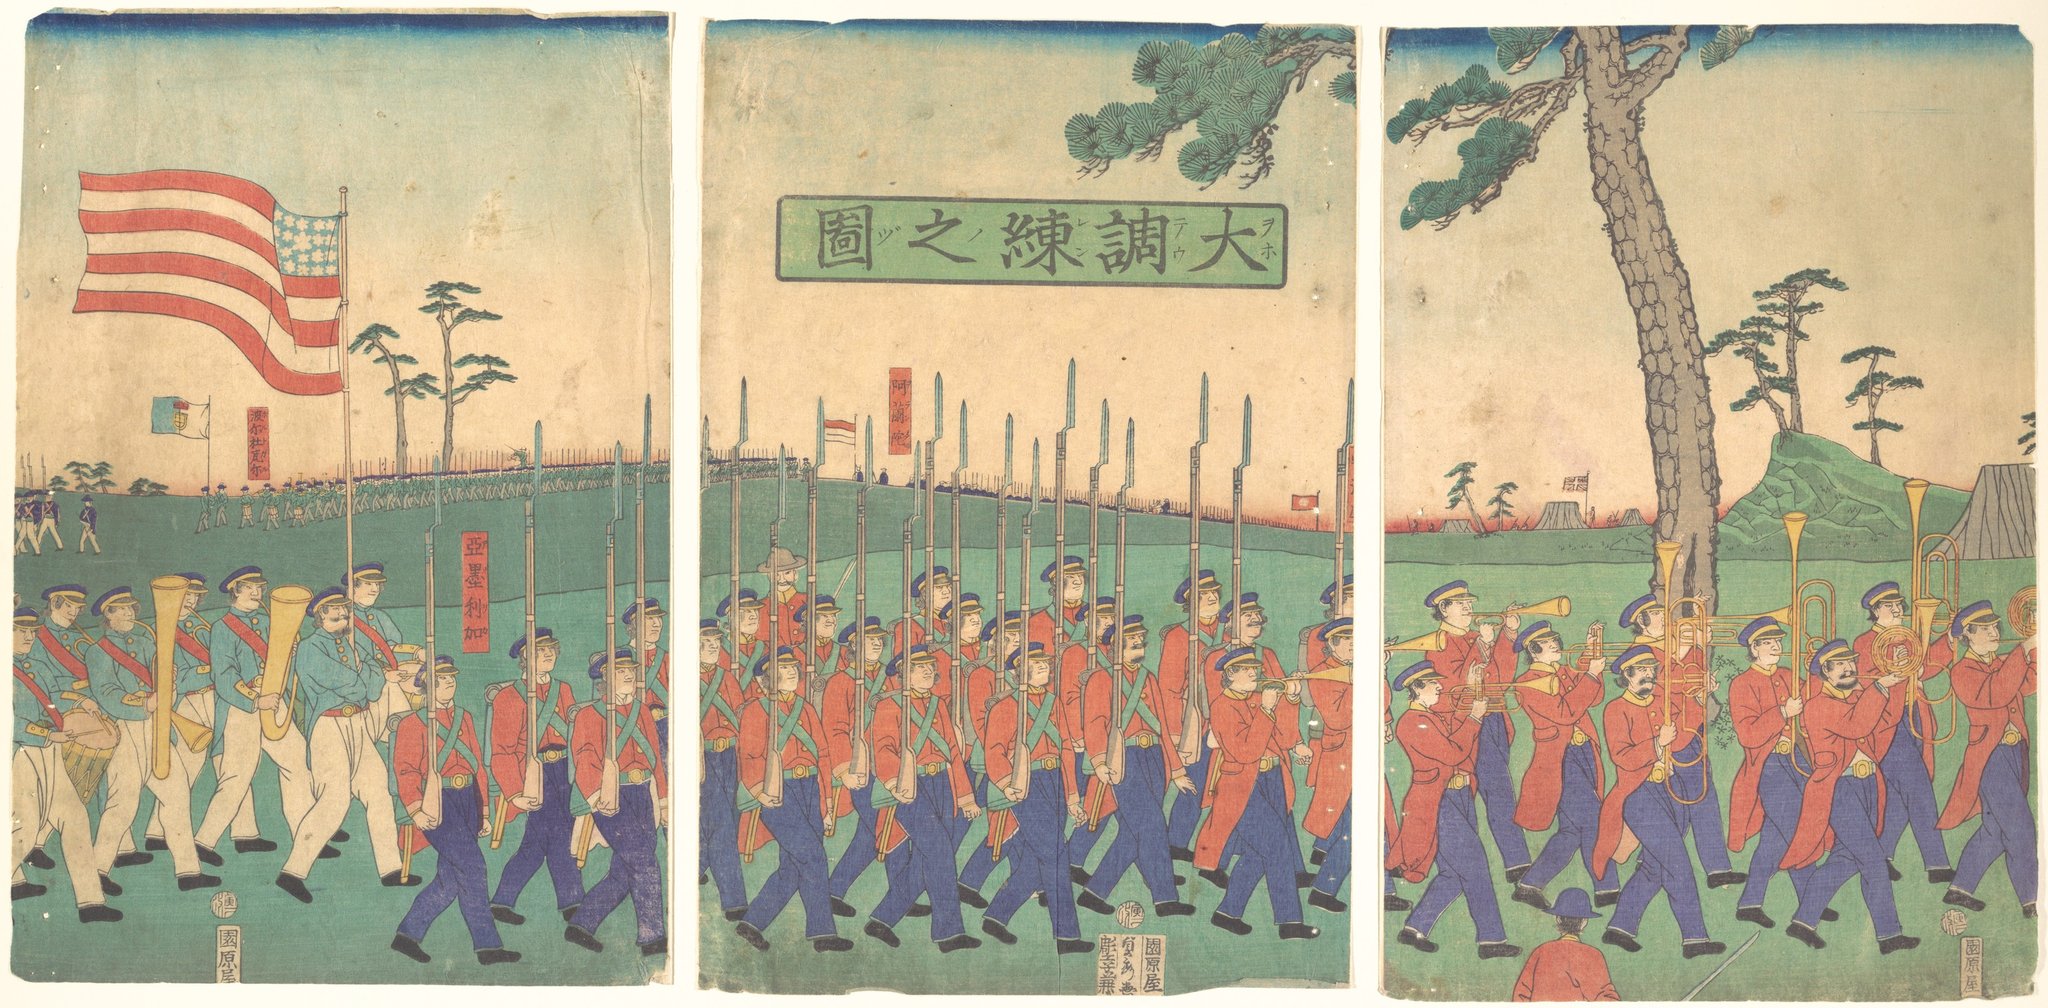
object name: print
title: Great Military Drill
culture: japanese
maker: utagawa (gountei) sadahide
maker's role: artist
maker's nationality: japanese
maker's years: 1807-1873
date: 1866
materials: ink, paper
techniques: woodblock print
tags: musical instruments,soldiers,men,musicians